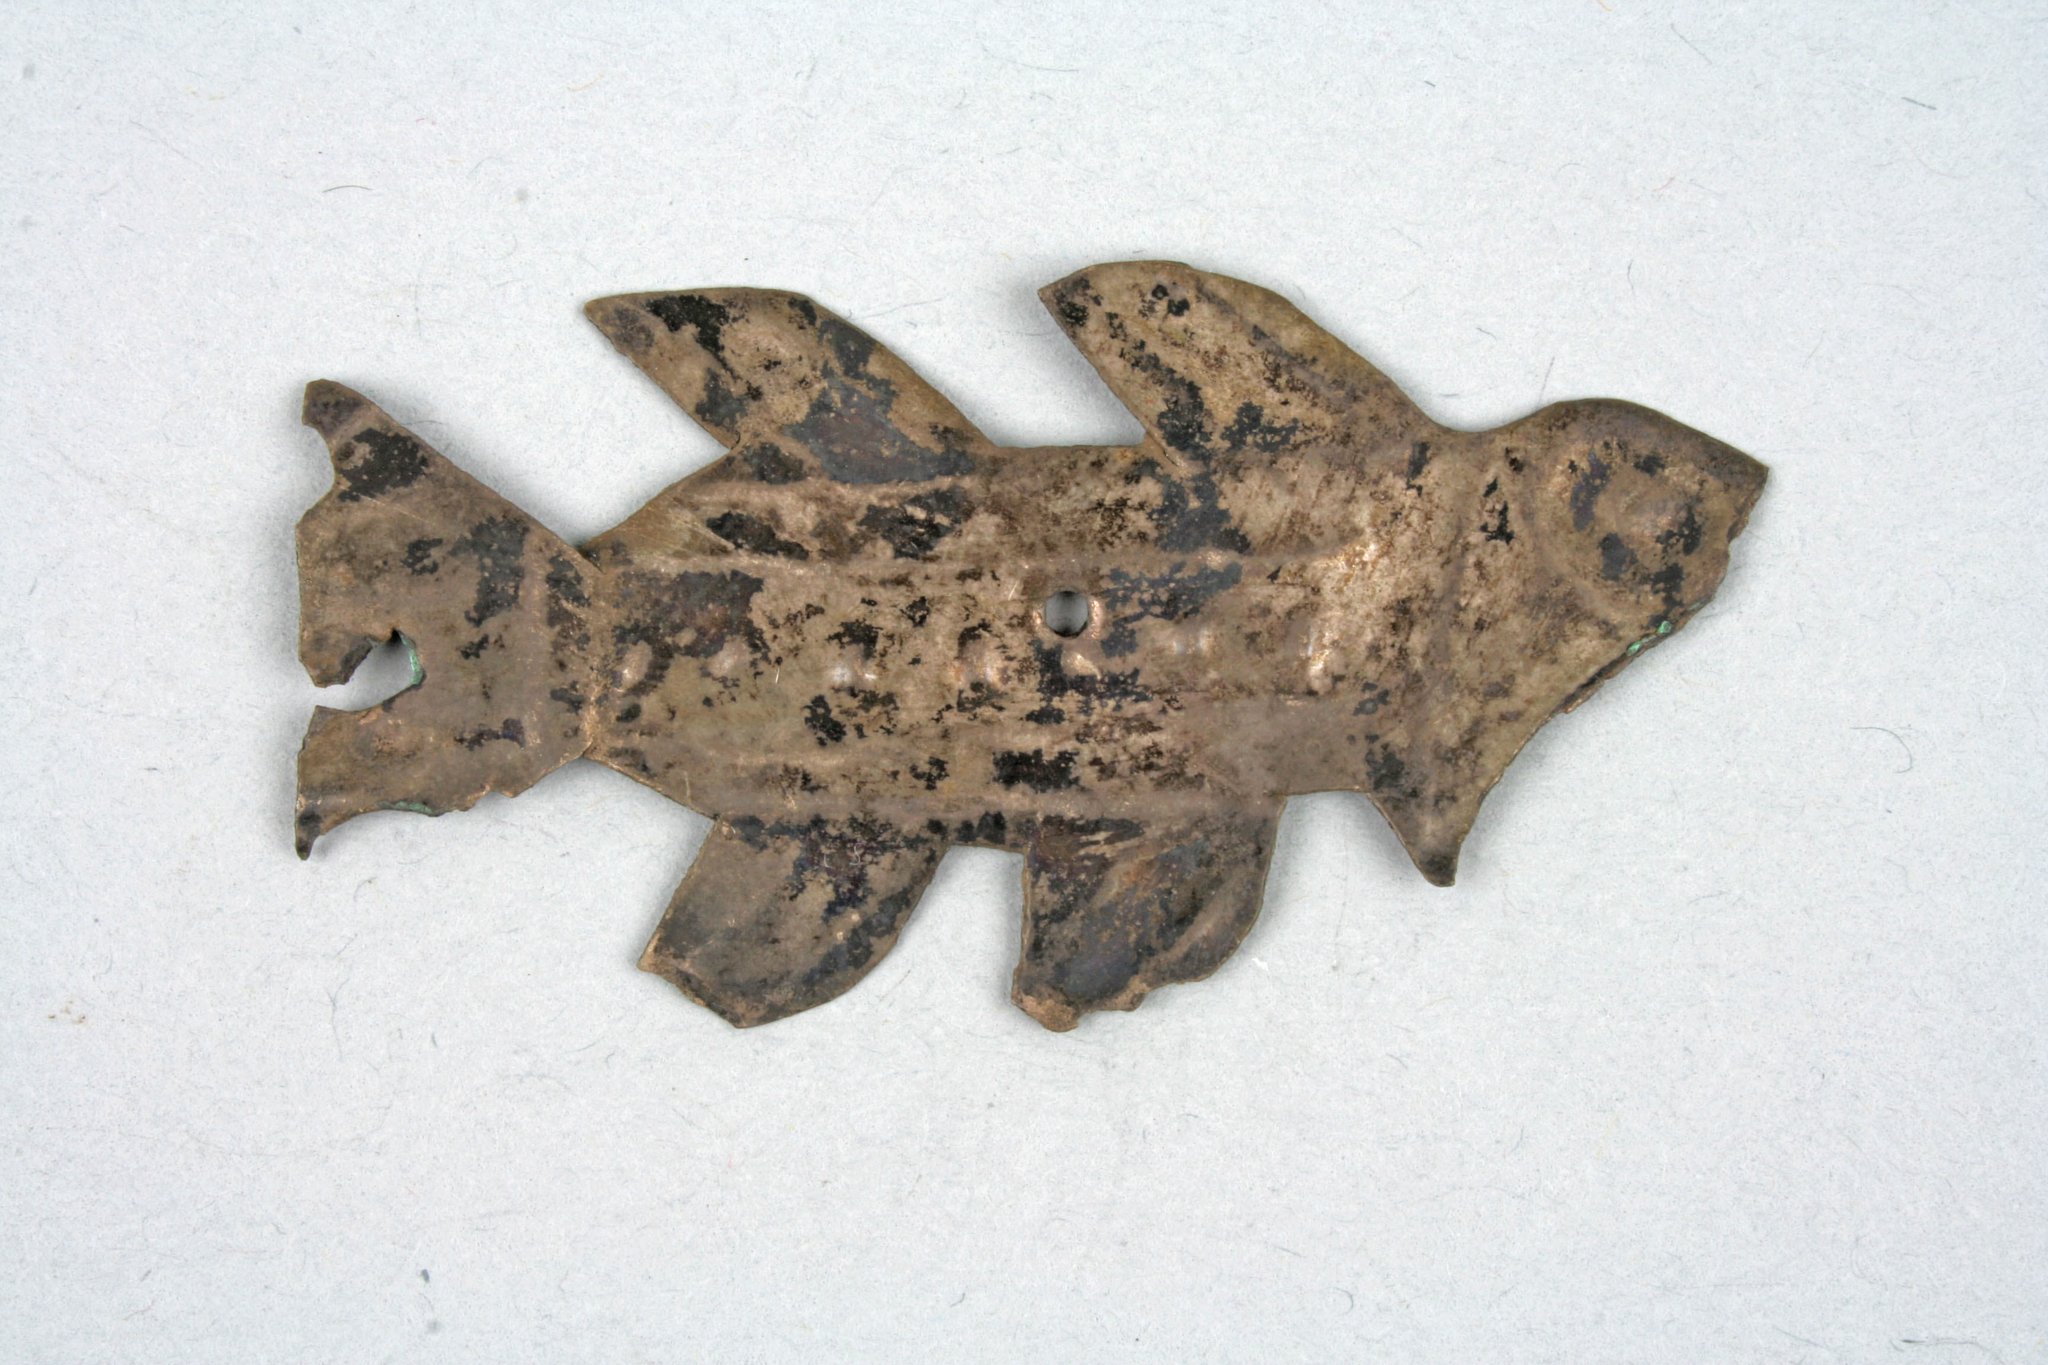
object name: costume ornament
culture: peruvian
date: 1001-1200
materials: silver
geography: peru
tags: fish